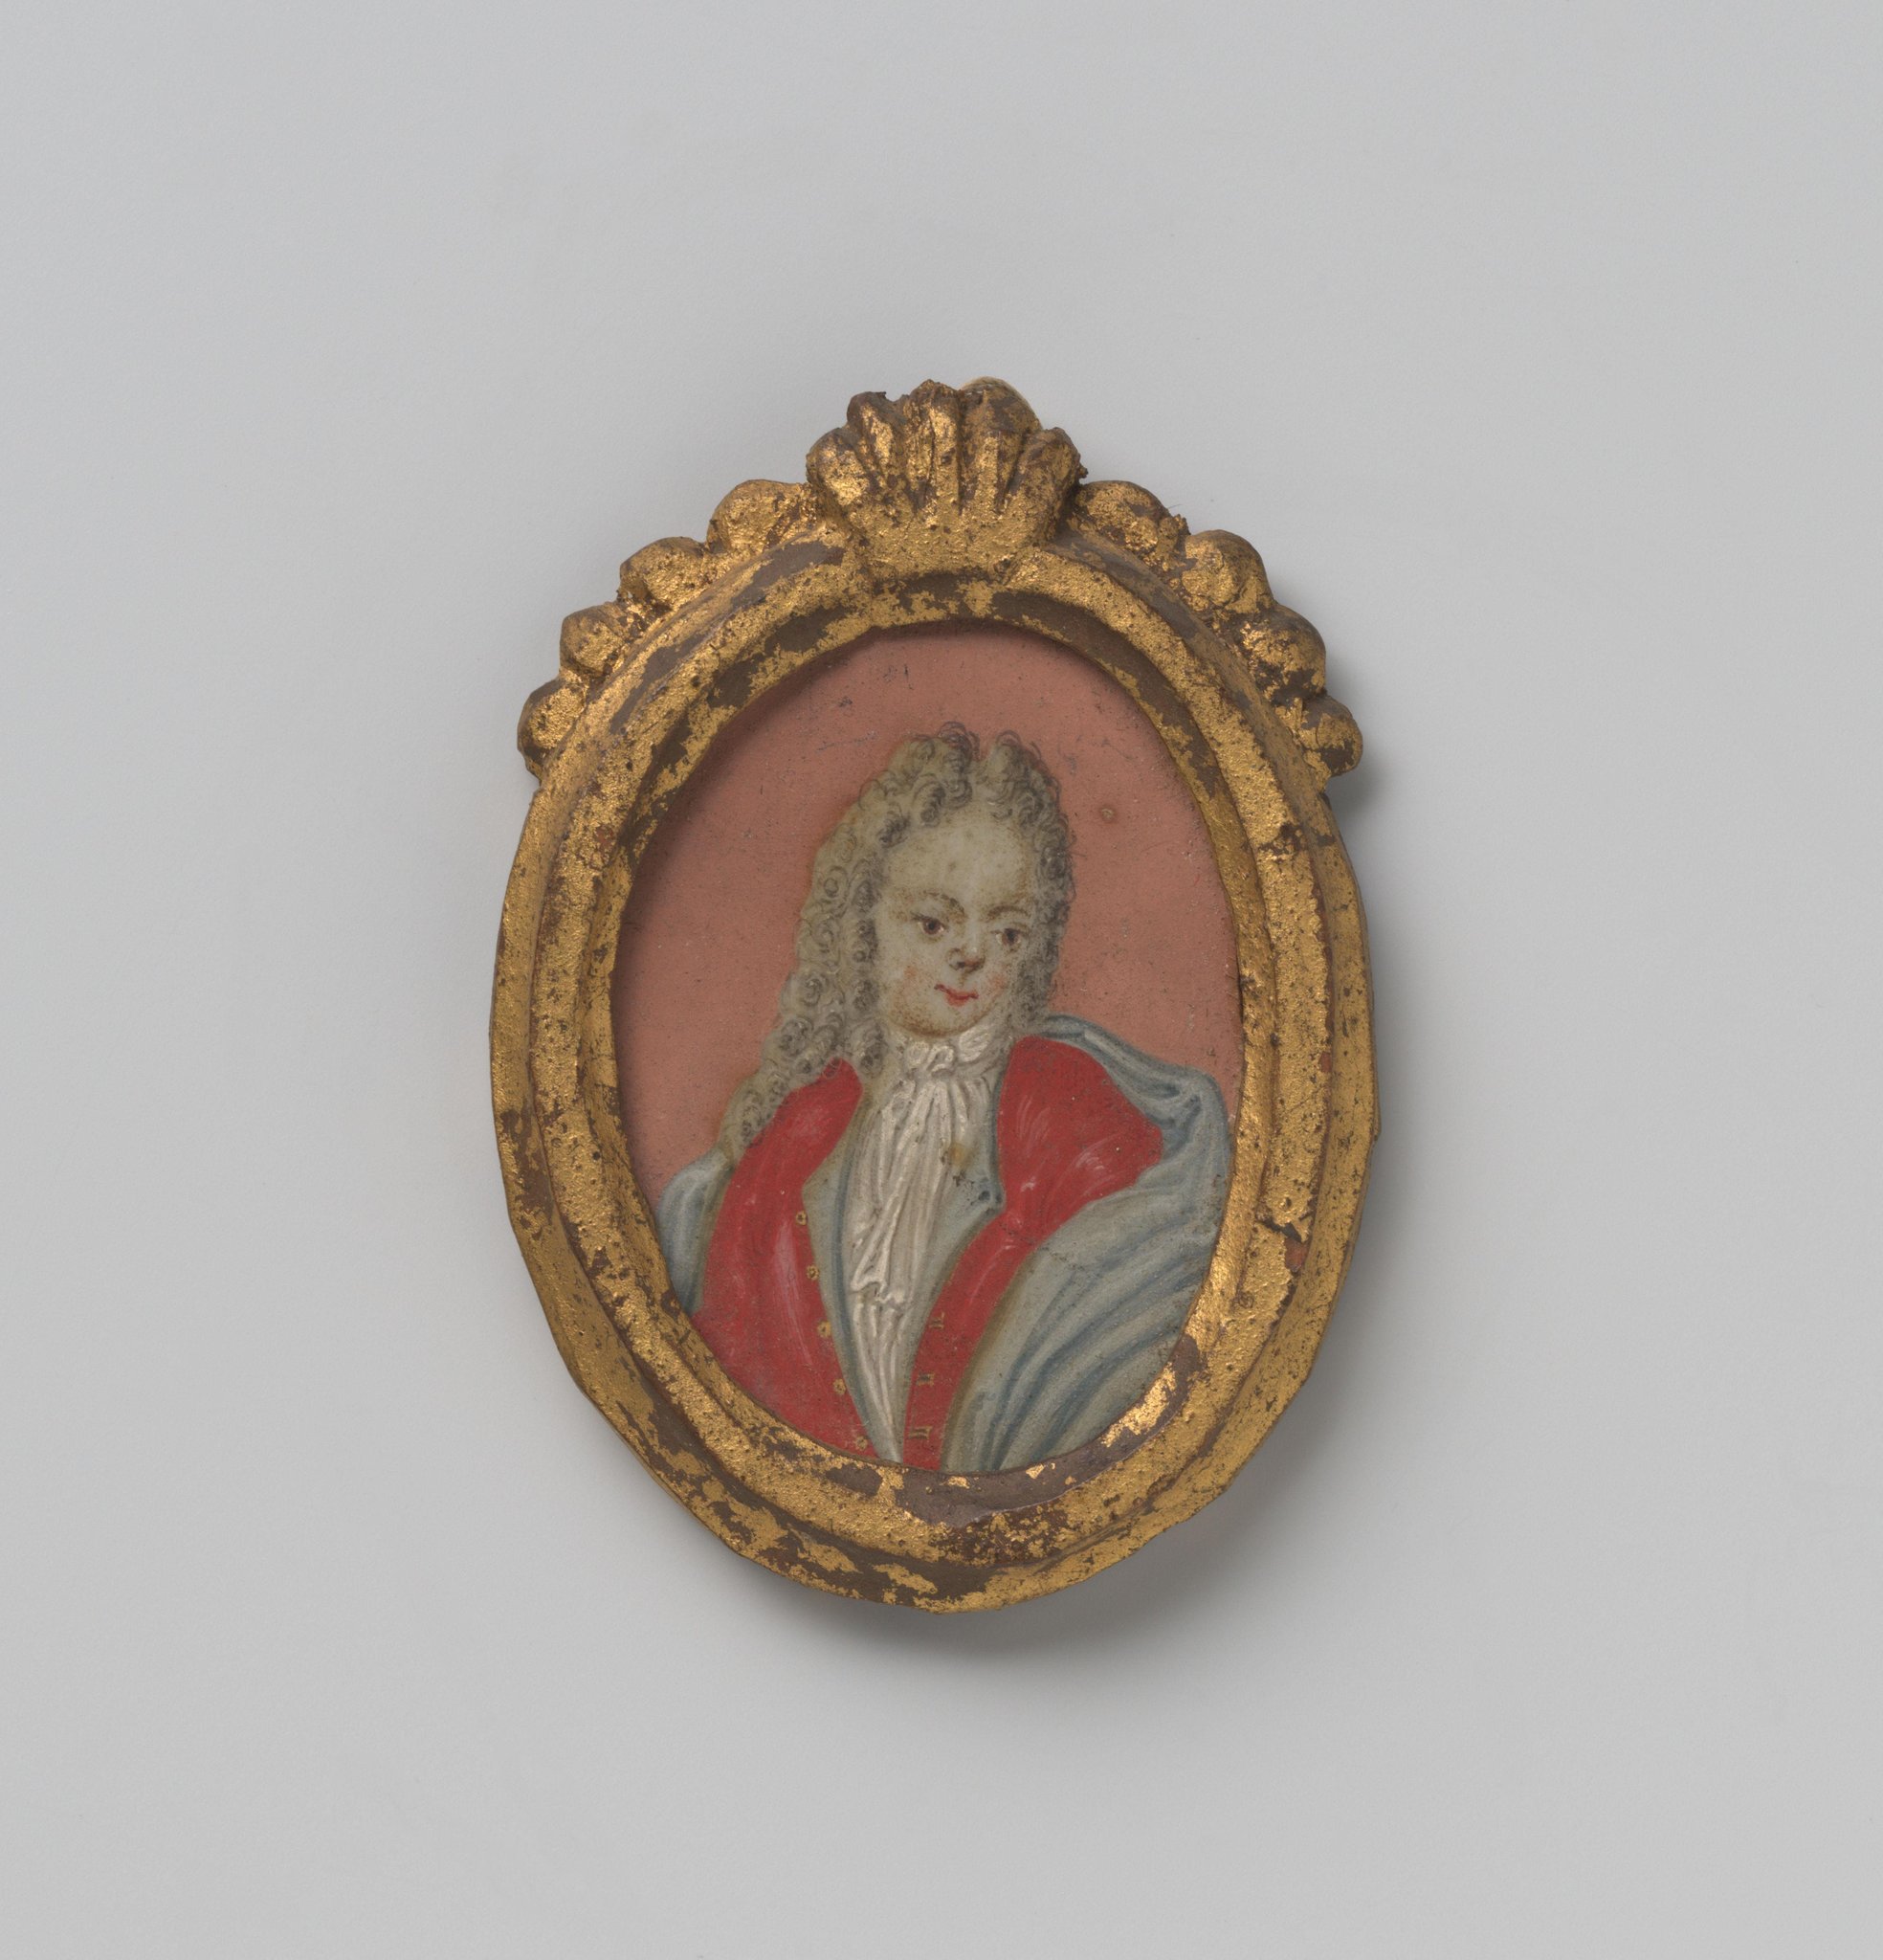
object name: miniature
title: Schilderij met het portret van een onbekende man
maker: Anonymous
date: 1700-1724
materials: gouache, ivory, wood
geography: netherlands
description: Schilderij met het portret van een onbekende man, buste, naar rechts kijkend, gekleed in een rode jas en grijsblauwe mantel, linnen hemd met strikdas. Op zijn hoofd een blonde, lange, gekrulde pruik. De achtergrond is roze. Gevat in een ovale vergulde lindehouten lijst met schelpmotief en 'parels' bovenop.